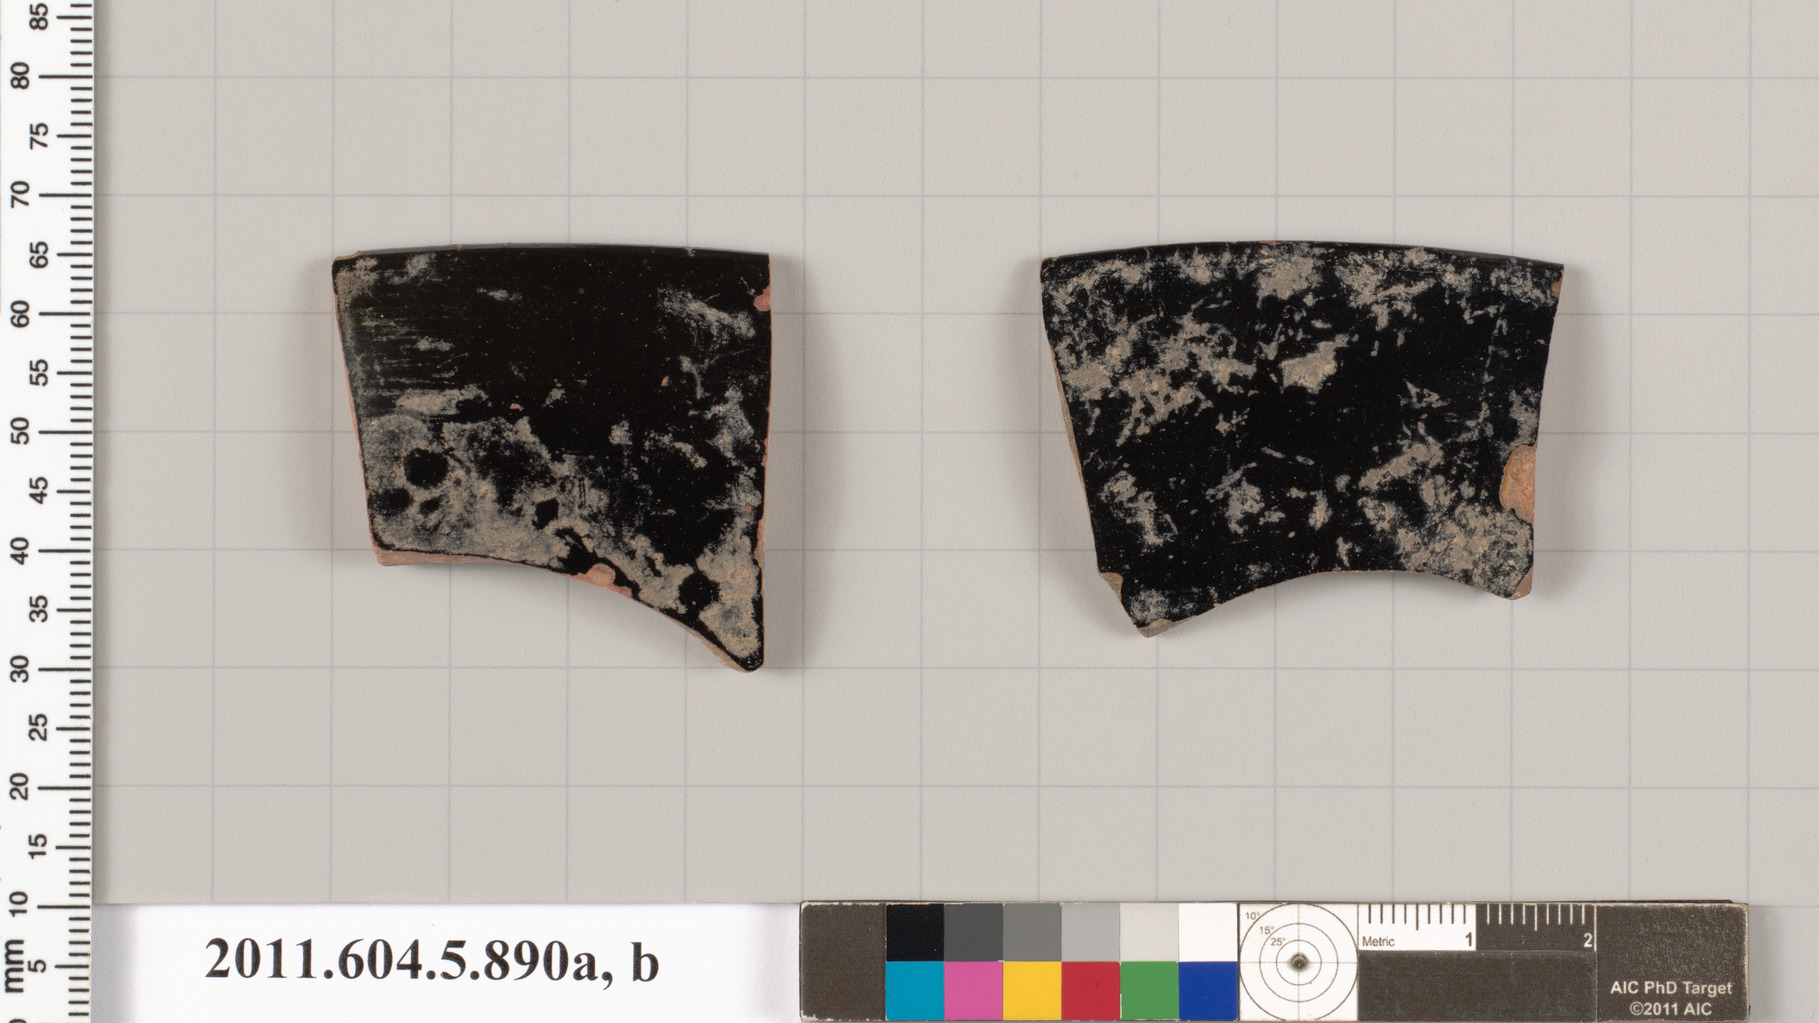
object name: kylix fragment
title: Terracotta rim fragments of kylikes (drinking cups)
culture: greek, attic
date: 600-401 BCE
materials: terracotta